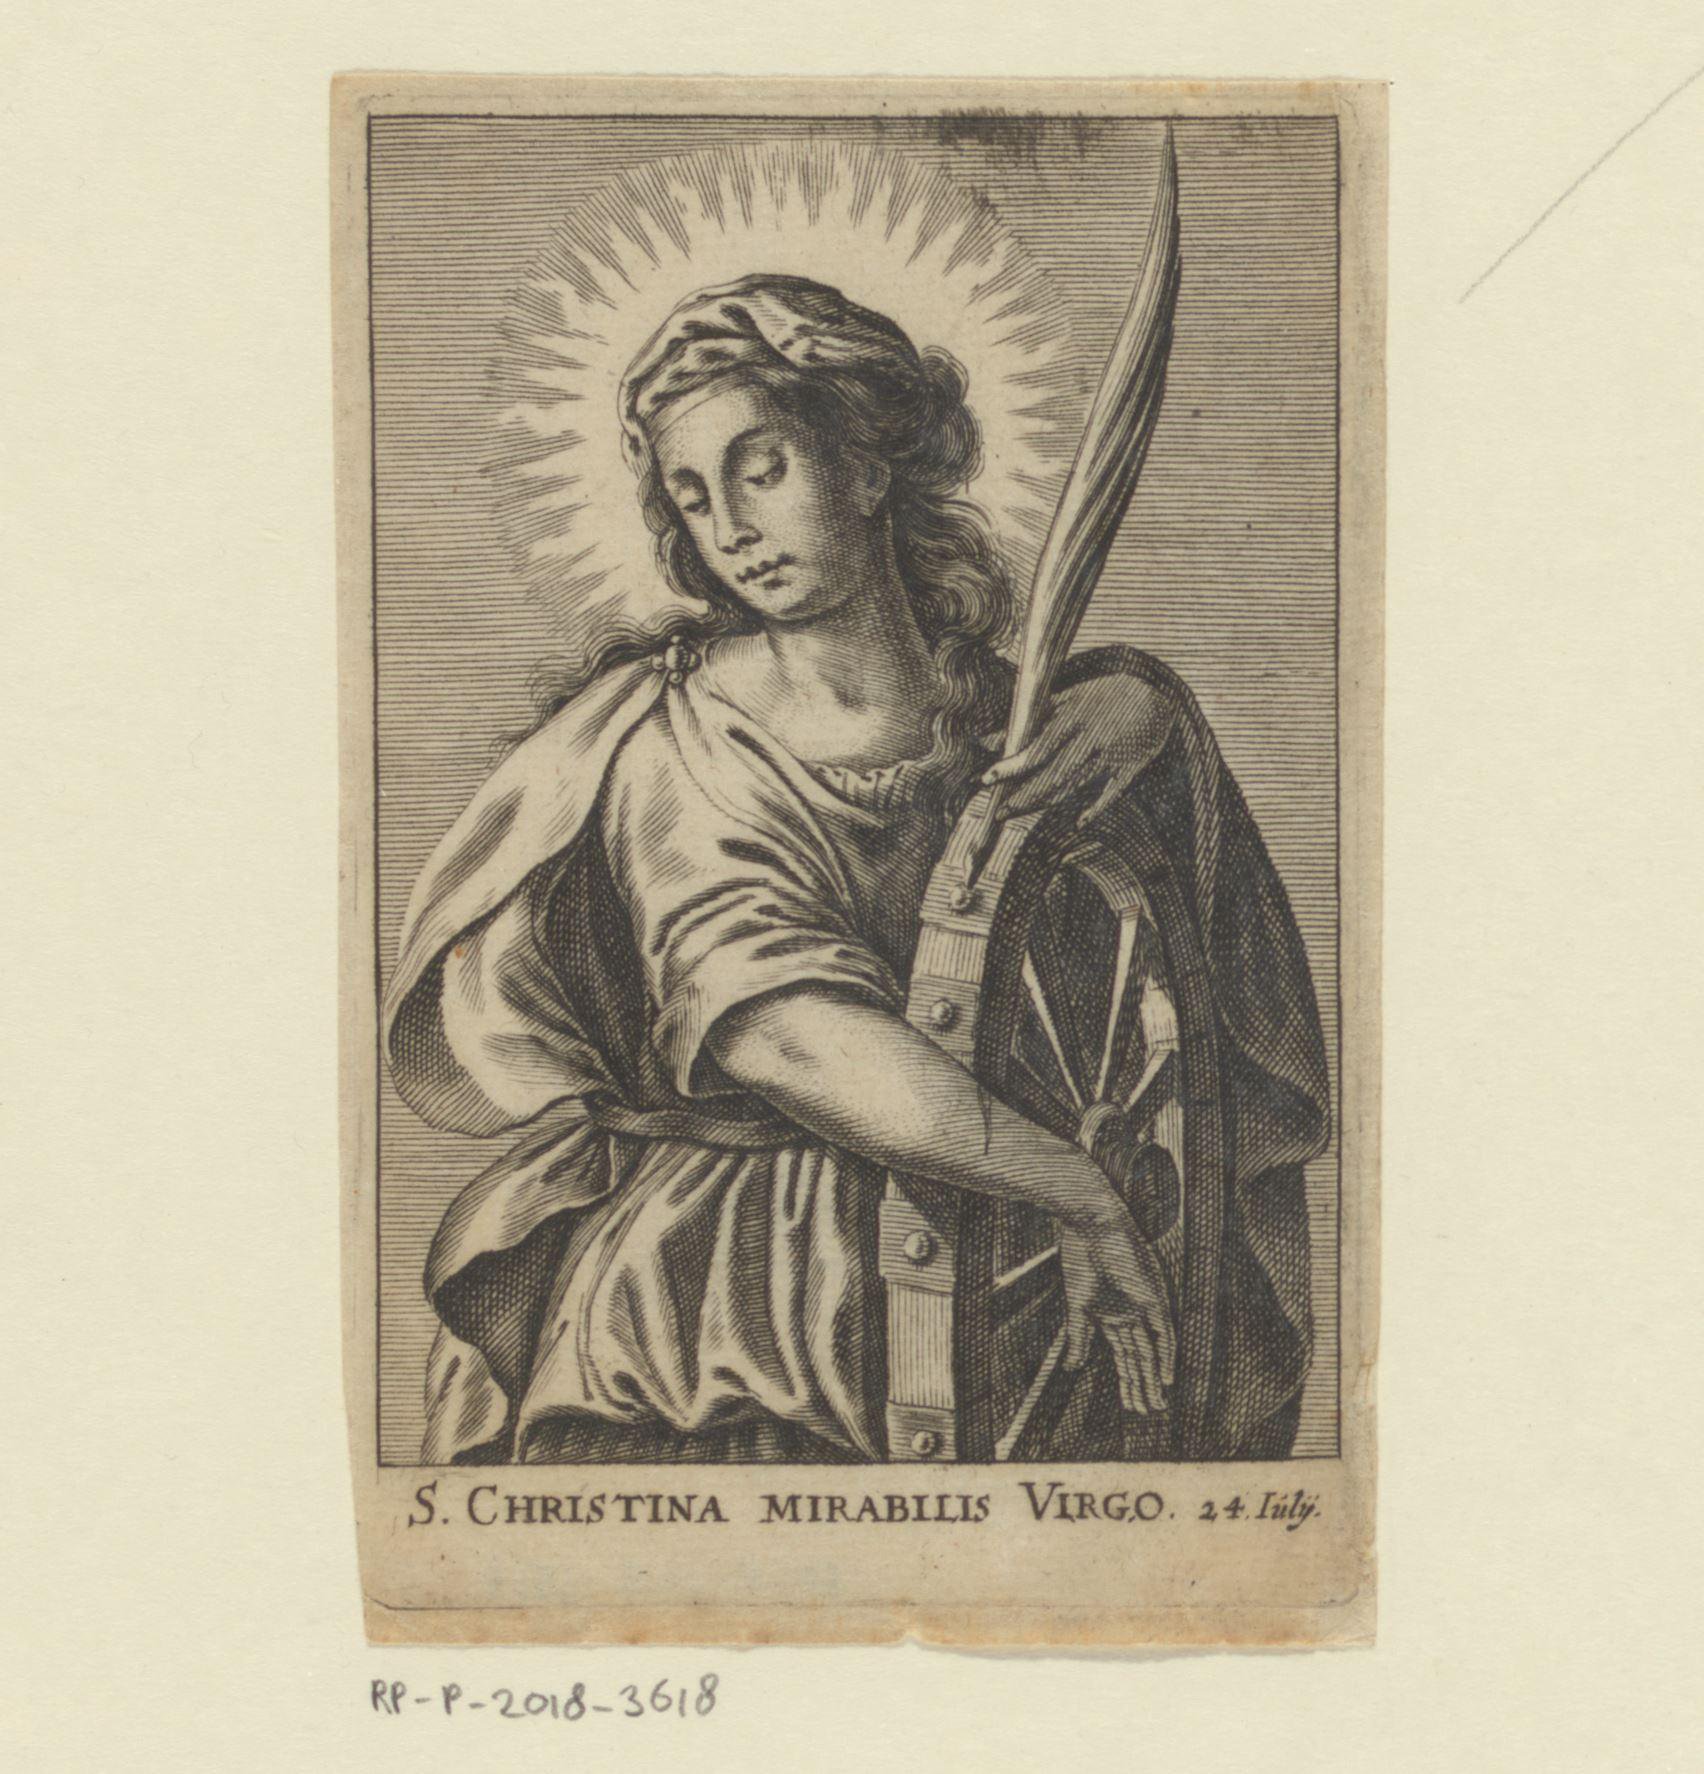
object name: print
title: S. Christina Mirablilis Virgo. 24 Iulij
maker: Anonymous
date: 1600-1700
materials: paper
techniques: engraving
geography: netherlands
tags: the virgin martyr christina of bolsena; possible attributes: arrow(s), book, flames, millstone, tongs, snake, wheel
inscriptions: collector's mark: Lugt 2228